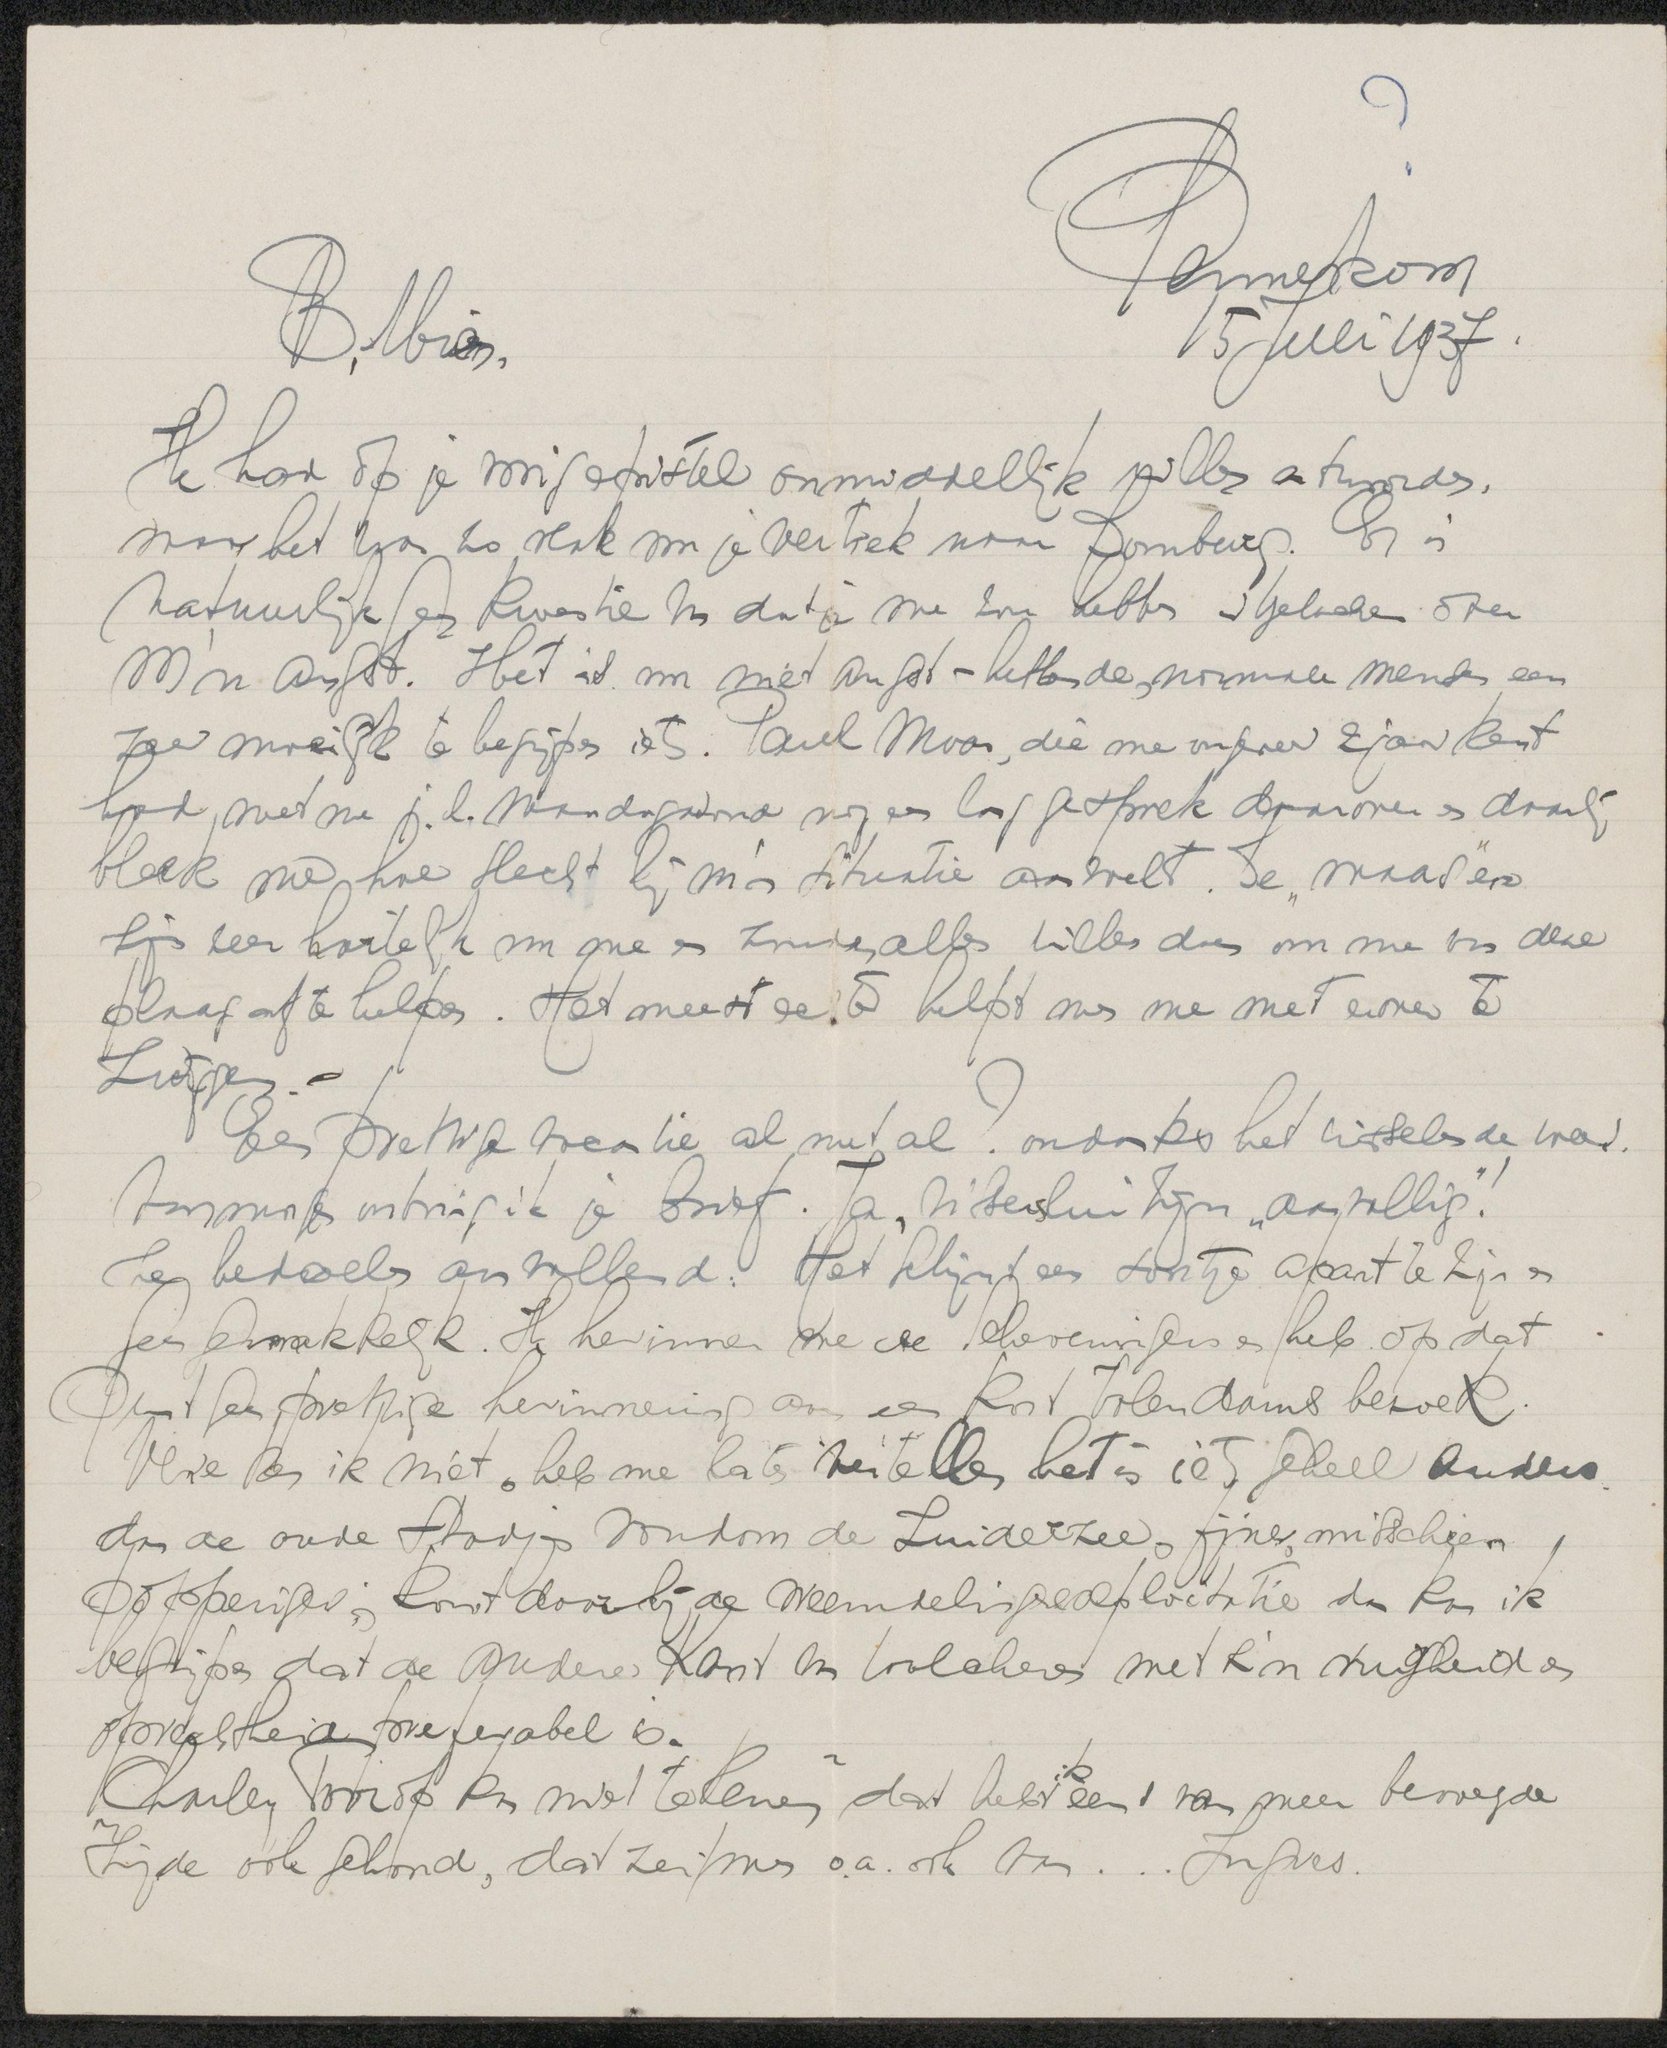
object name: letter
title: Brief aan Mien Cambier van Nooten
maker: dick ket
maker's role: draughtsman, print maker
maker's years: 1902-1940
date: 1937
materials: ink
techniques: pen, writing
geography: bennekom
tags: grave, arnhem, print maker, draughtsman, mien cambier van nooten, charley toorop, drawing, travelling; tourism, diseases, historical persons (portraits and scenes from the life)